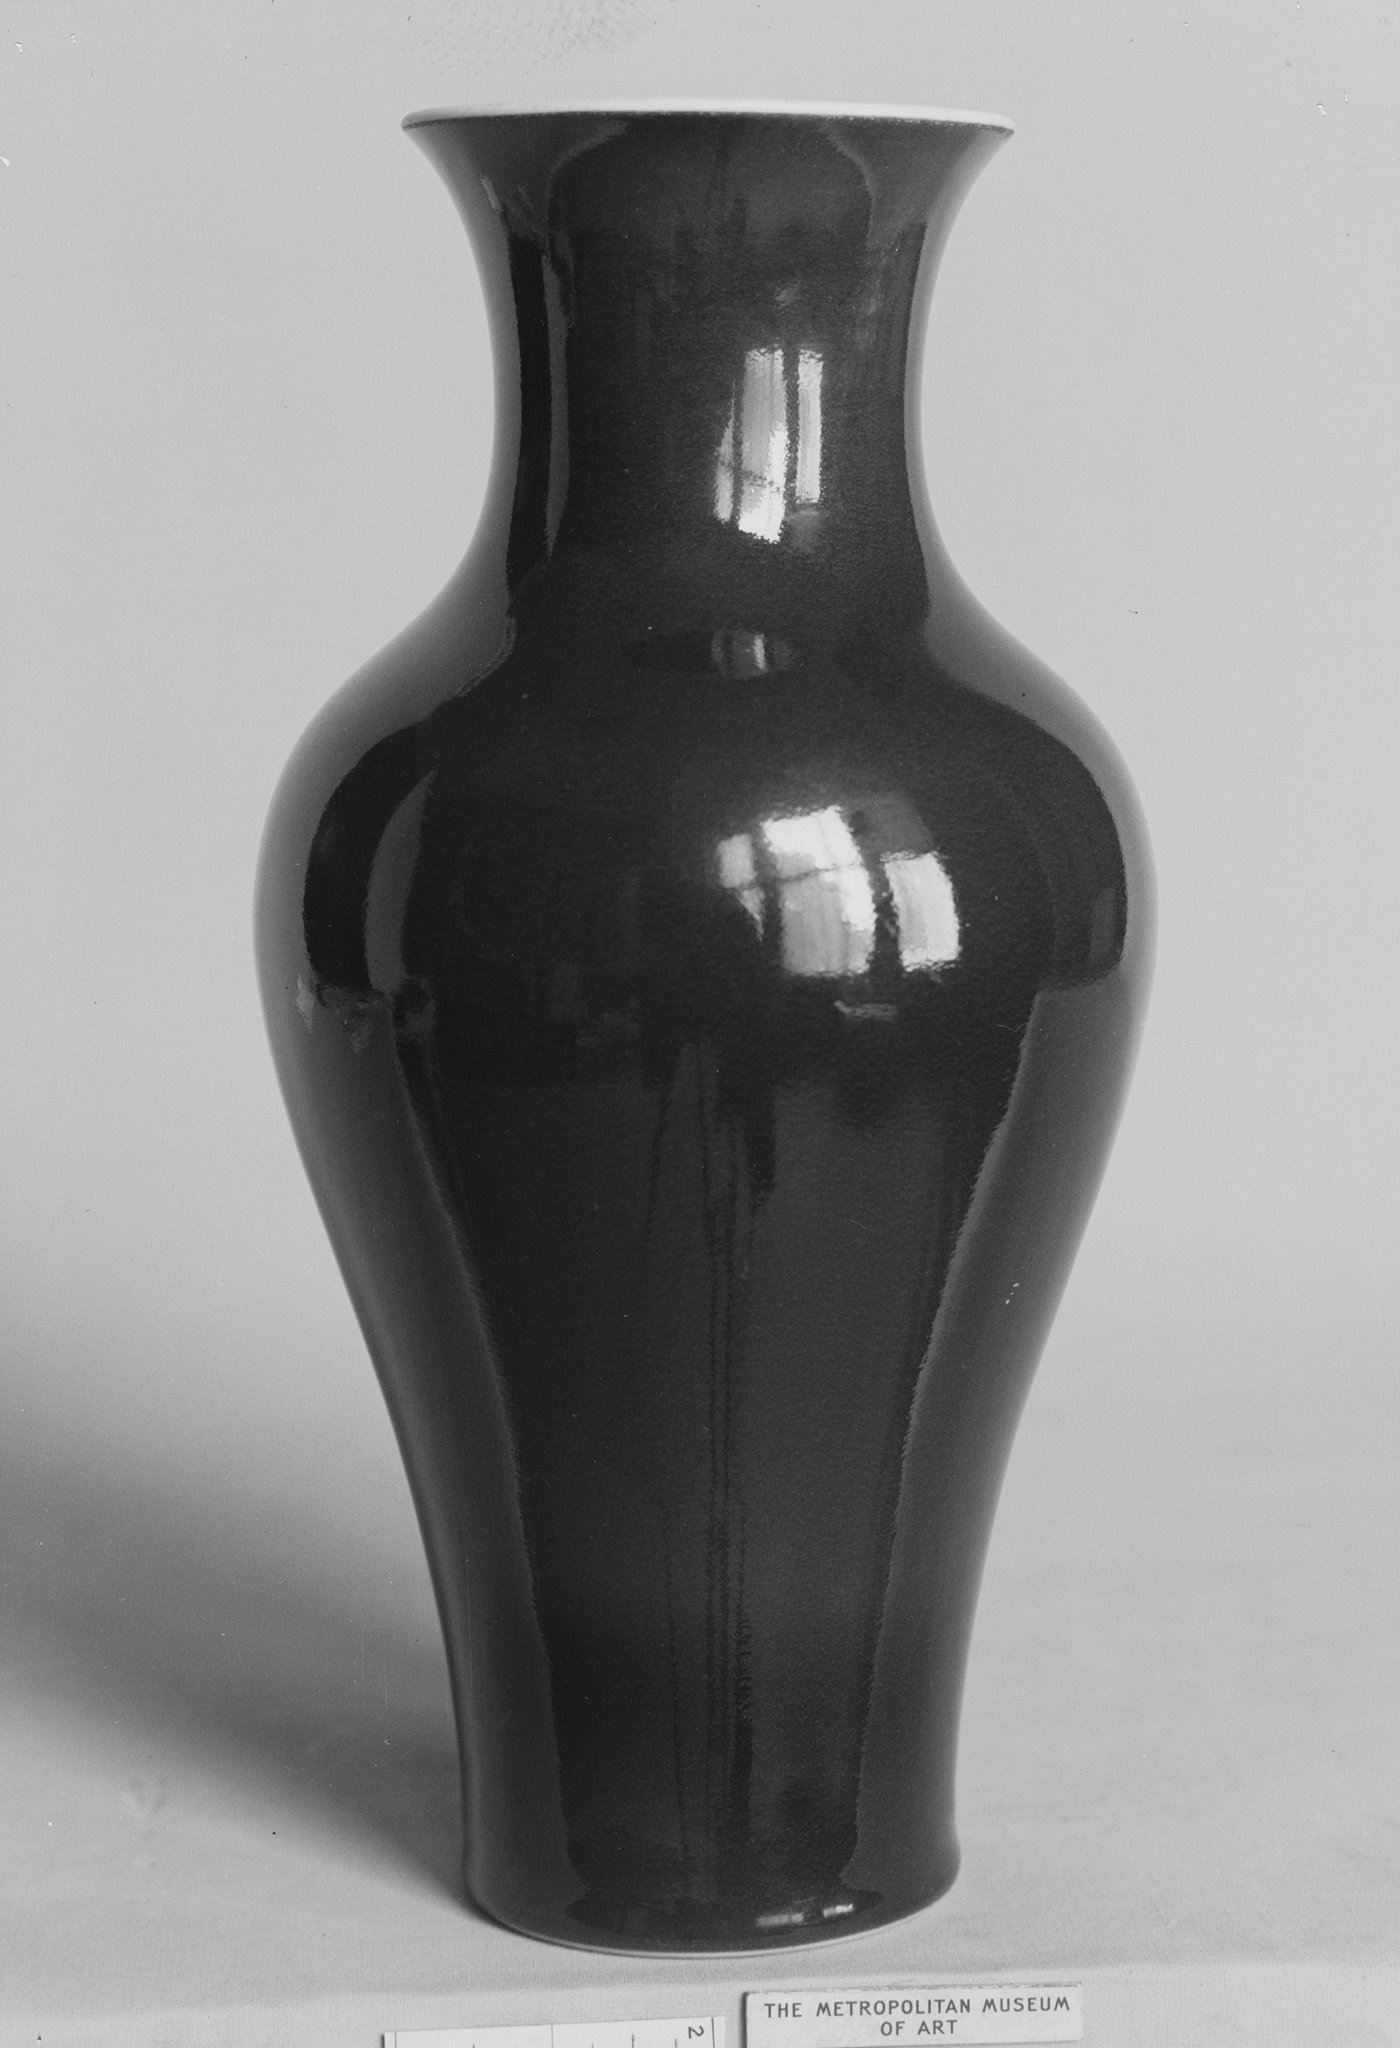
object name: vase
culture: chinese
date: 1723-1735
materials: porcelain